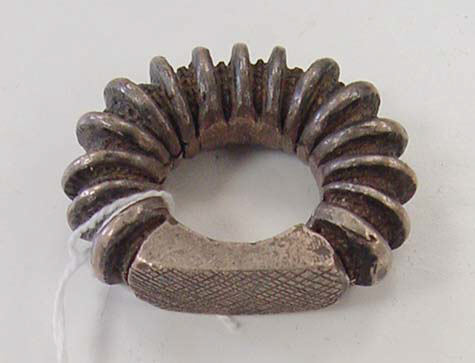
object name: ring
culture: african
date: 1801-1900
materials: metal